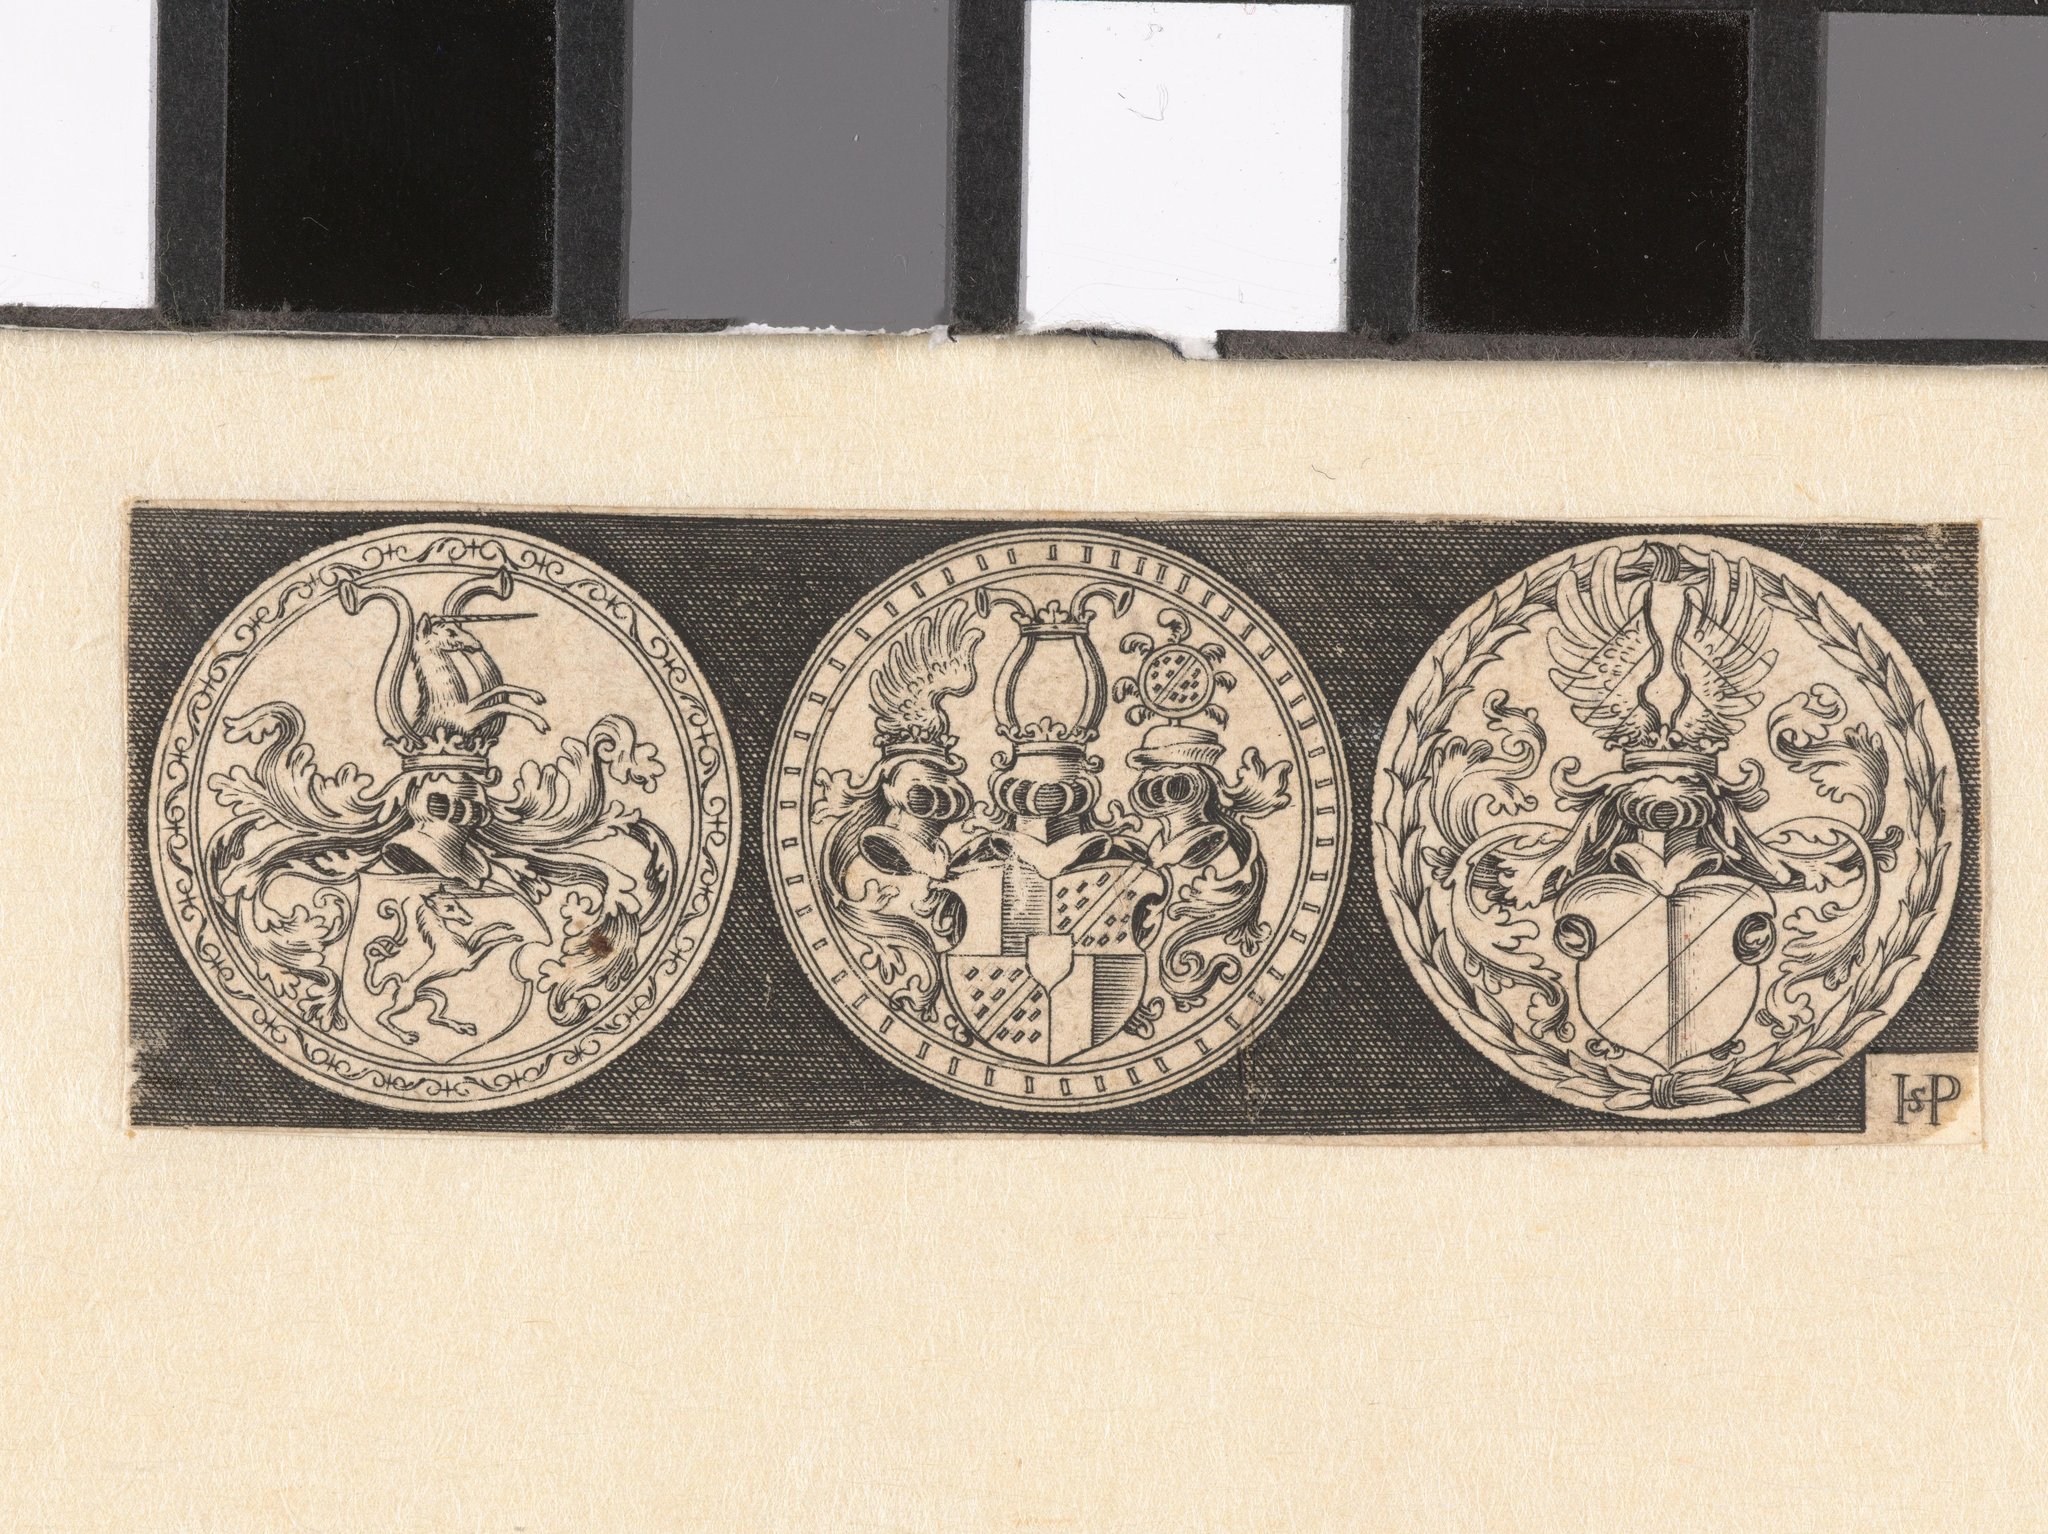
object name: design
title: Drie ontwerpen voor penningen met wapens op schilden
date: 1510-1599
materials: paper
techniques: engraving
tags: memorial medal, armorial bearing, heraldry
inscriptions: collector's mark: Lugt 240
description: Kopie in spiegelbeeld naar prent van Hans Sebald Beham